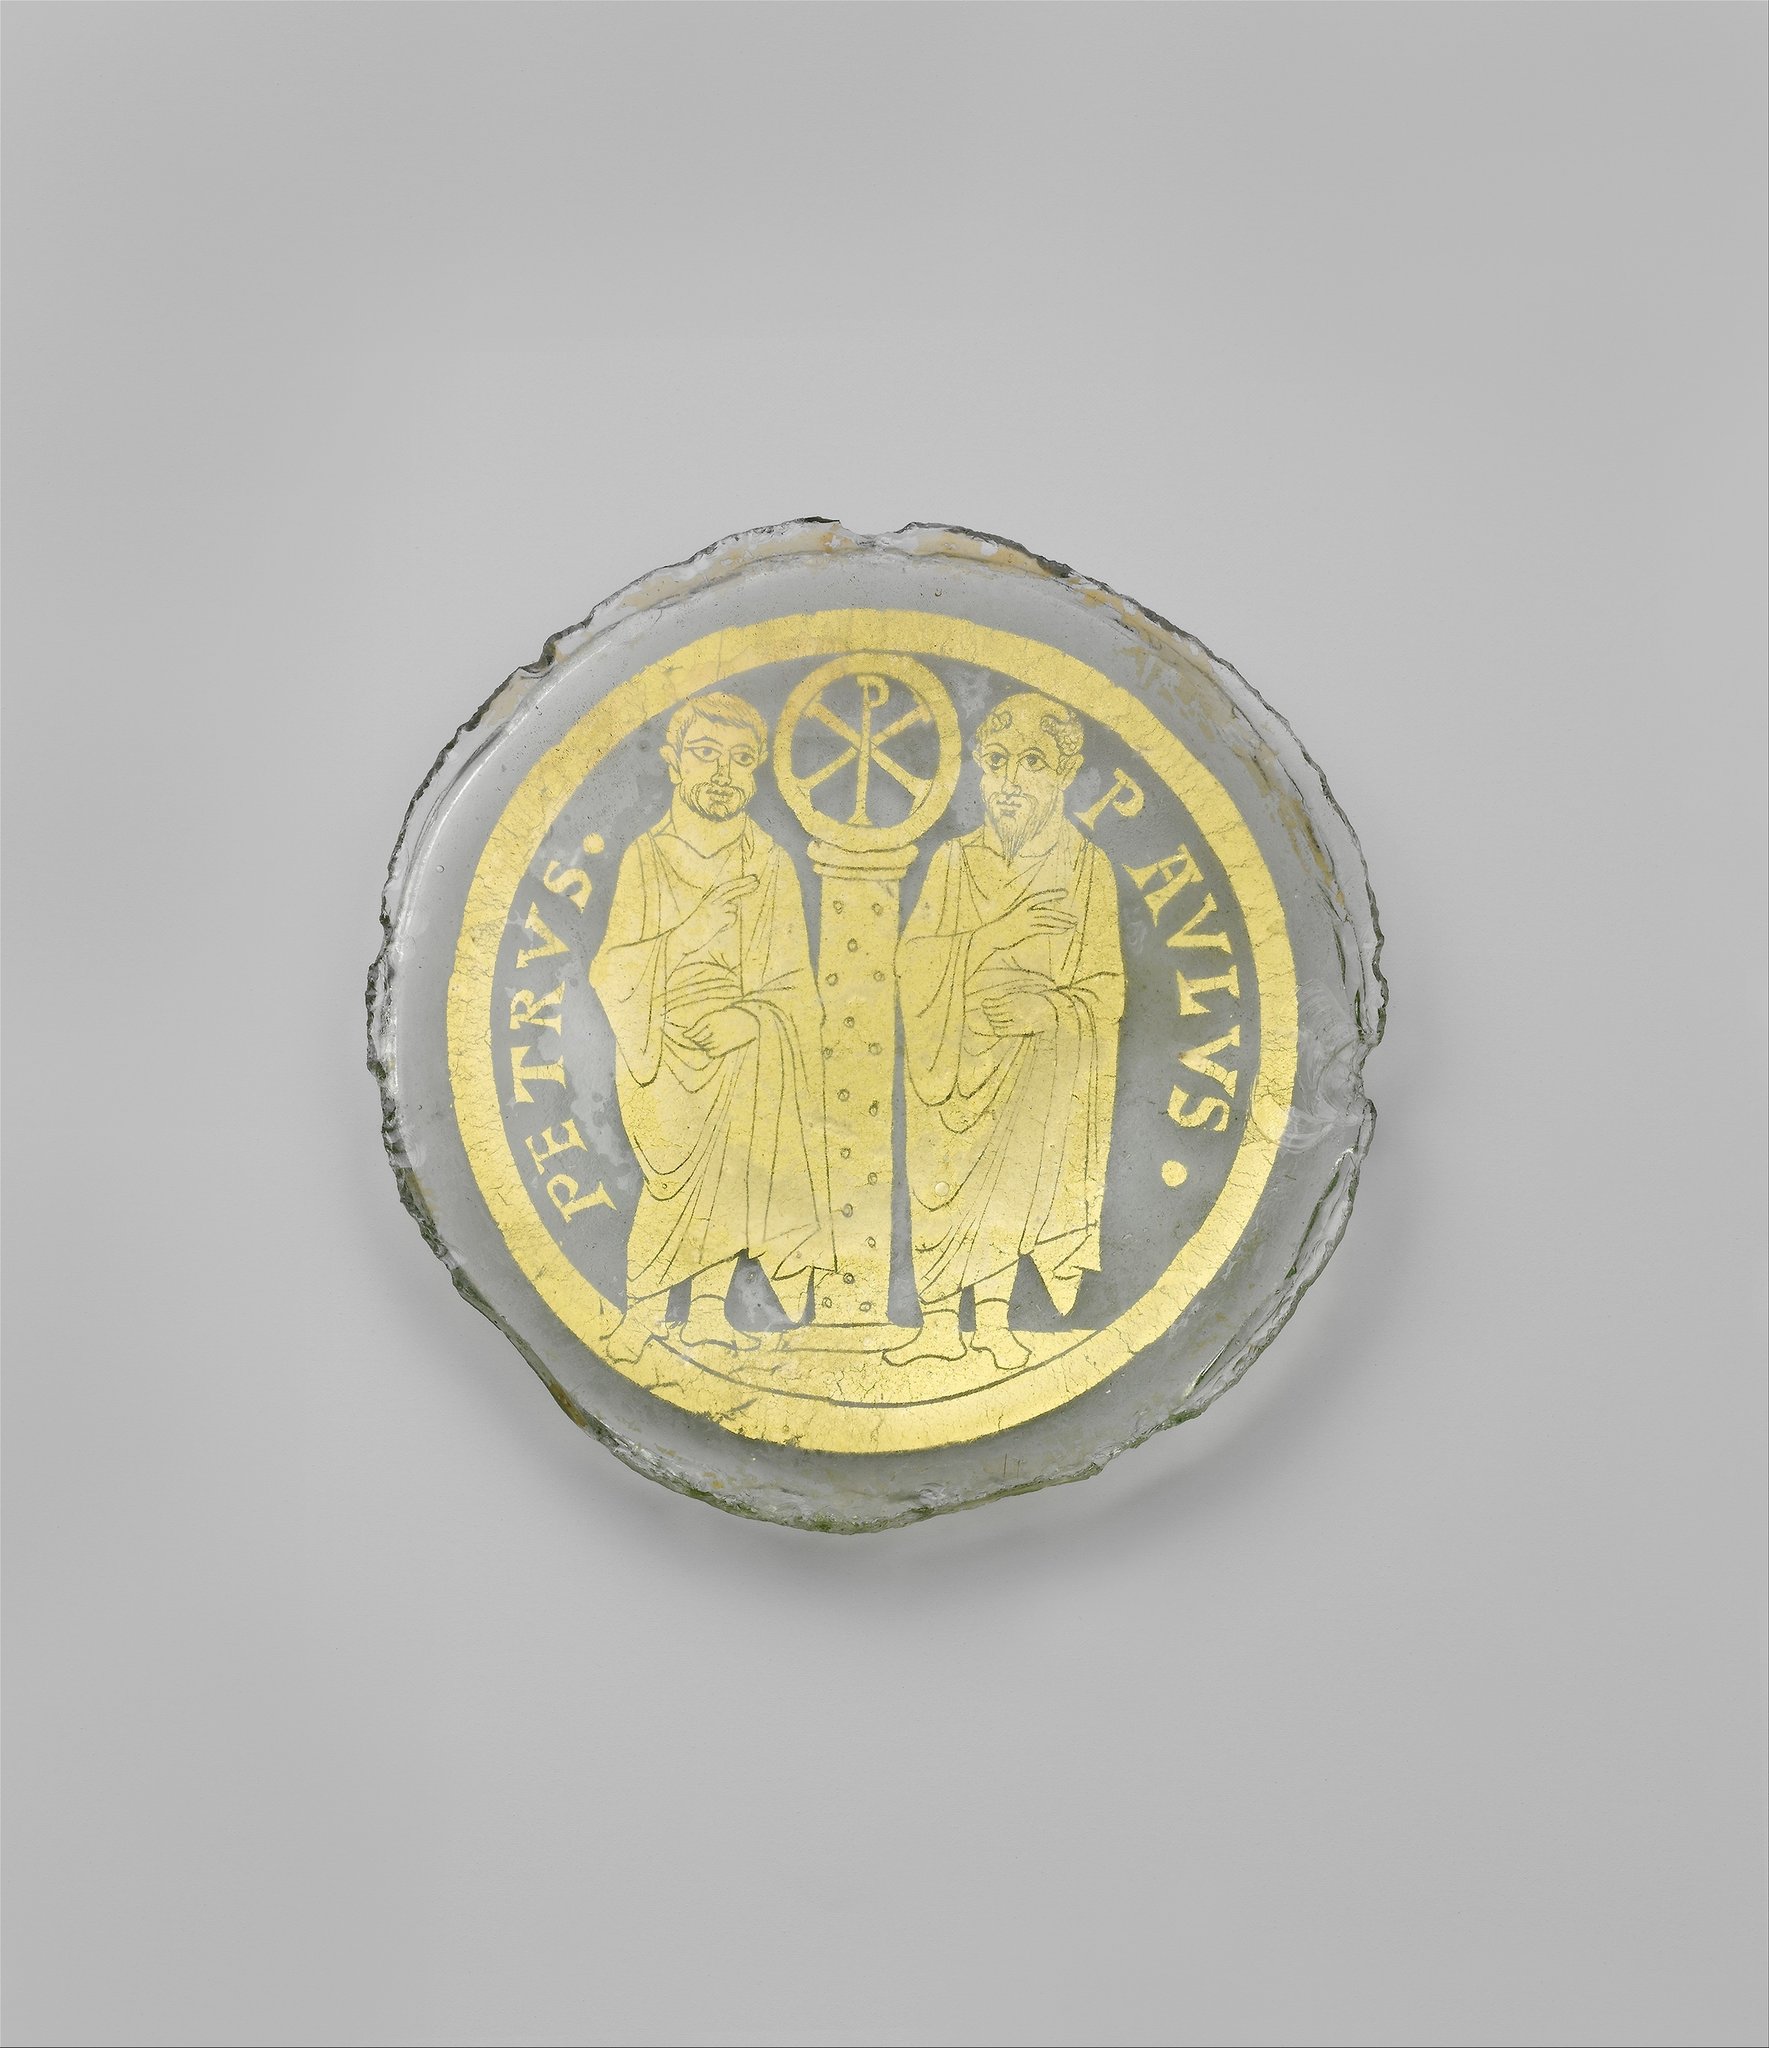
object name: bowl bottom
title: Bowl Base with Saints Peter and Paul Flanking a Column with the Christogram of Christ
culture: byzantine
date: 367-400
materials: glass, gold leaf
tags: men,saint paul,saint peter